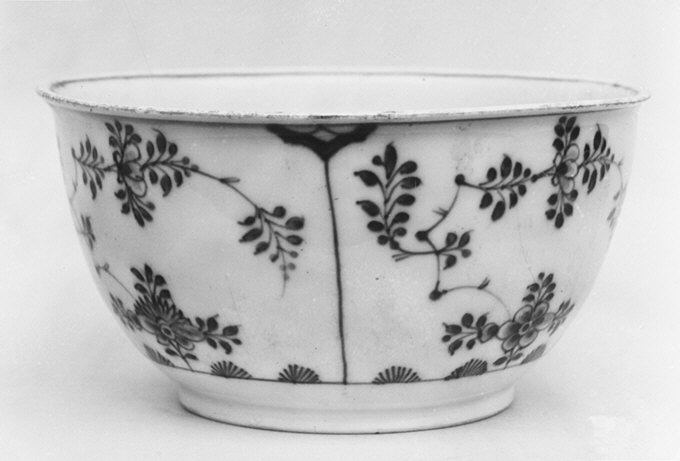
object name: bowl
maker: meissen manufactory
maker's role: manufactory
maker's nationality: german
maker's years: 1710-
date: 1760-1770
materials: hard paste porcelain